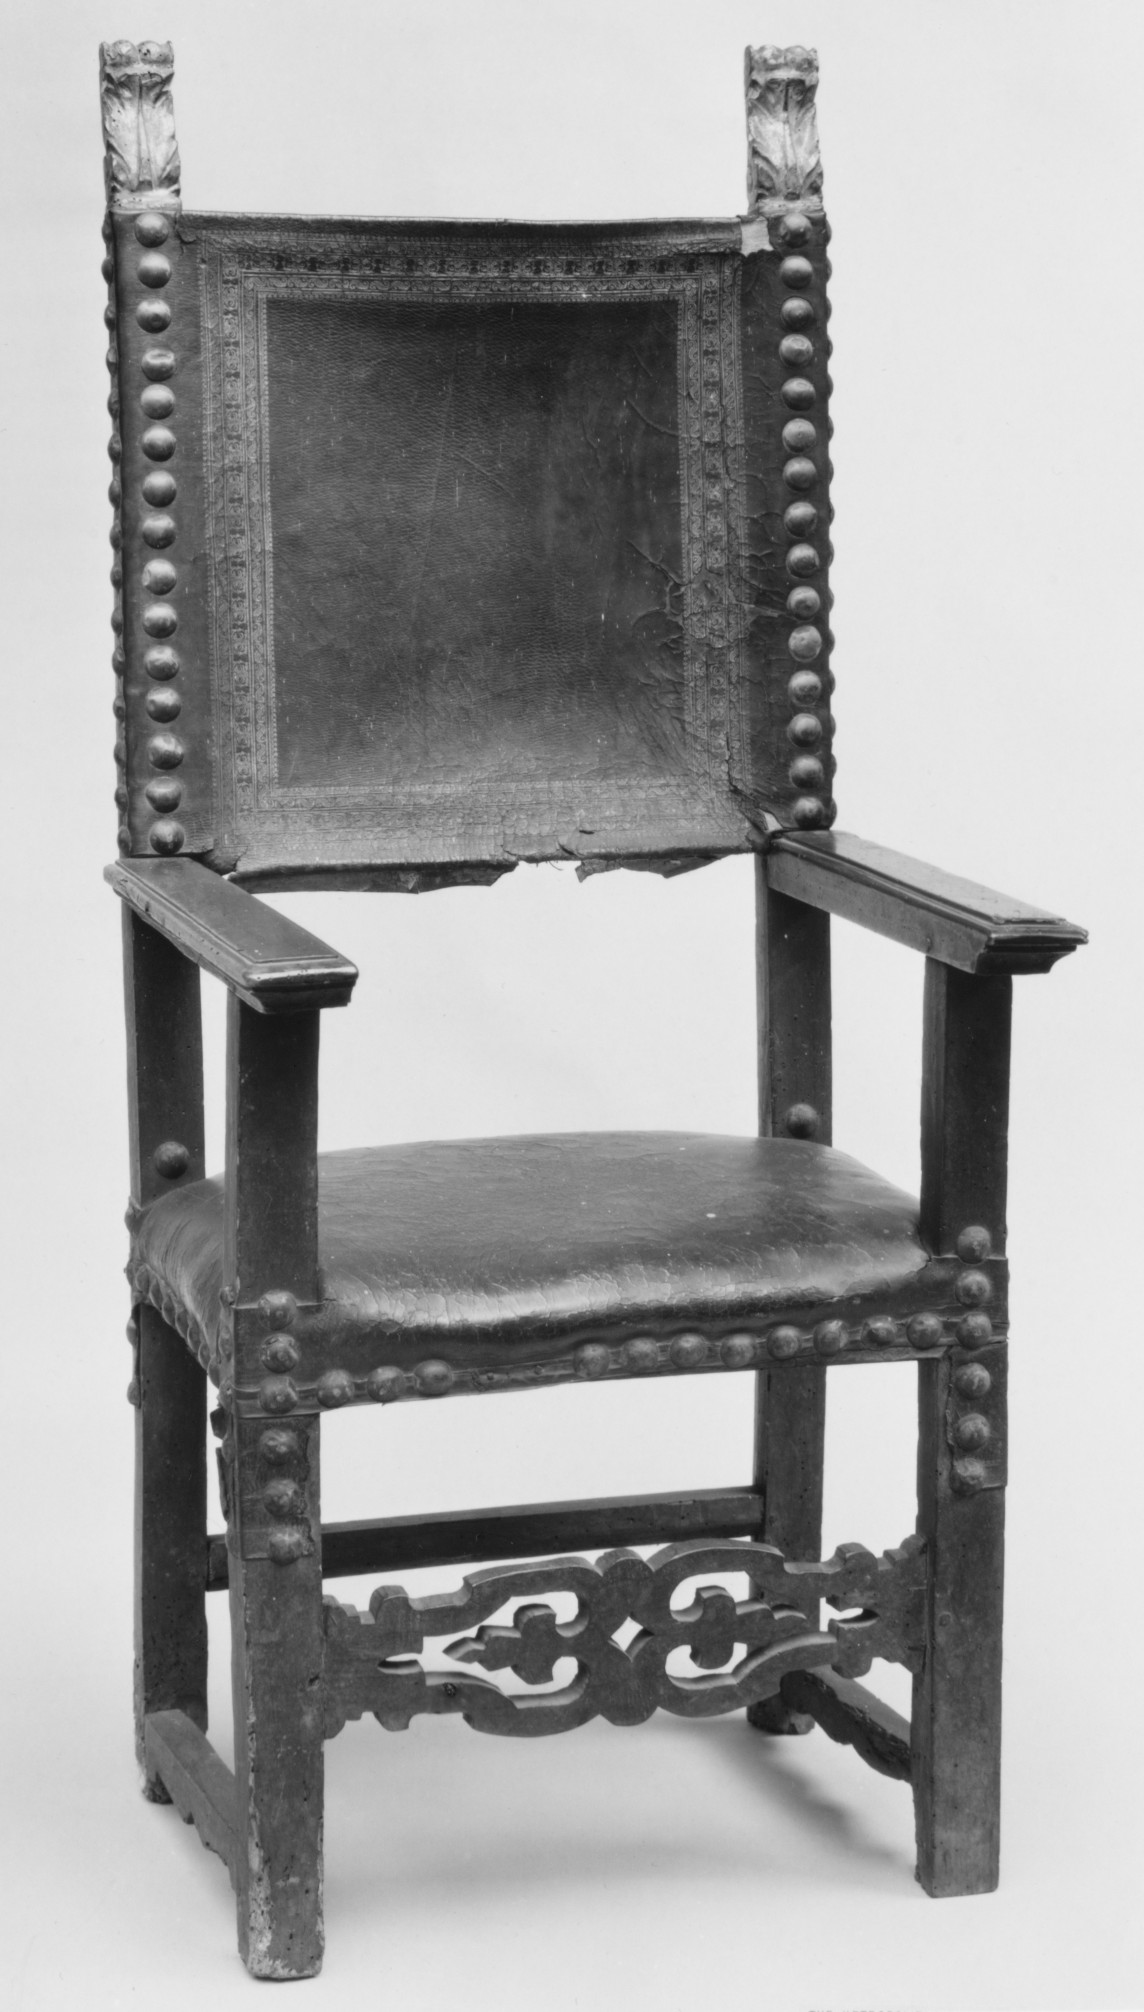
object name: armchair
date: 1567-1600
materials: leather, wood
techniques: carving, gilding